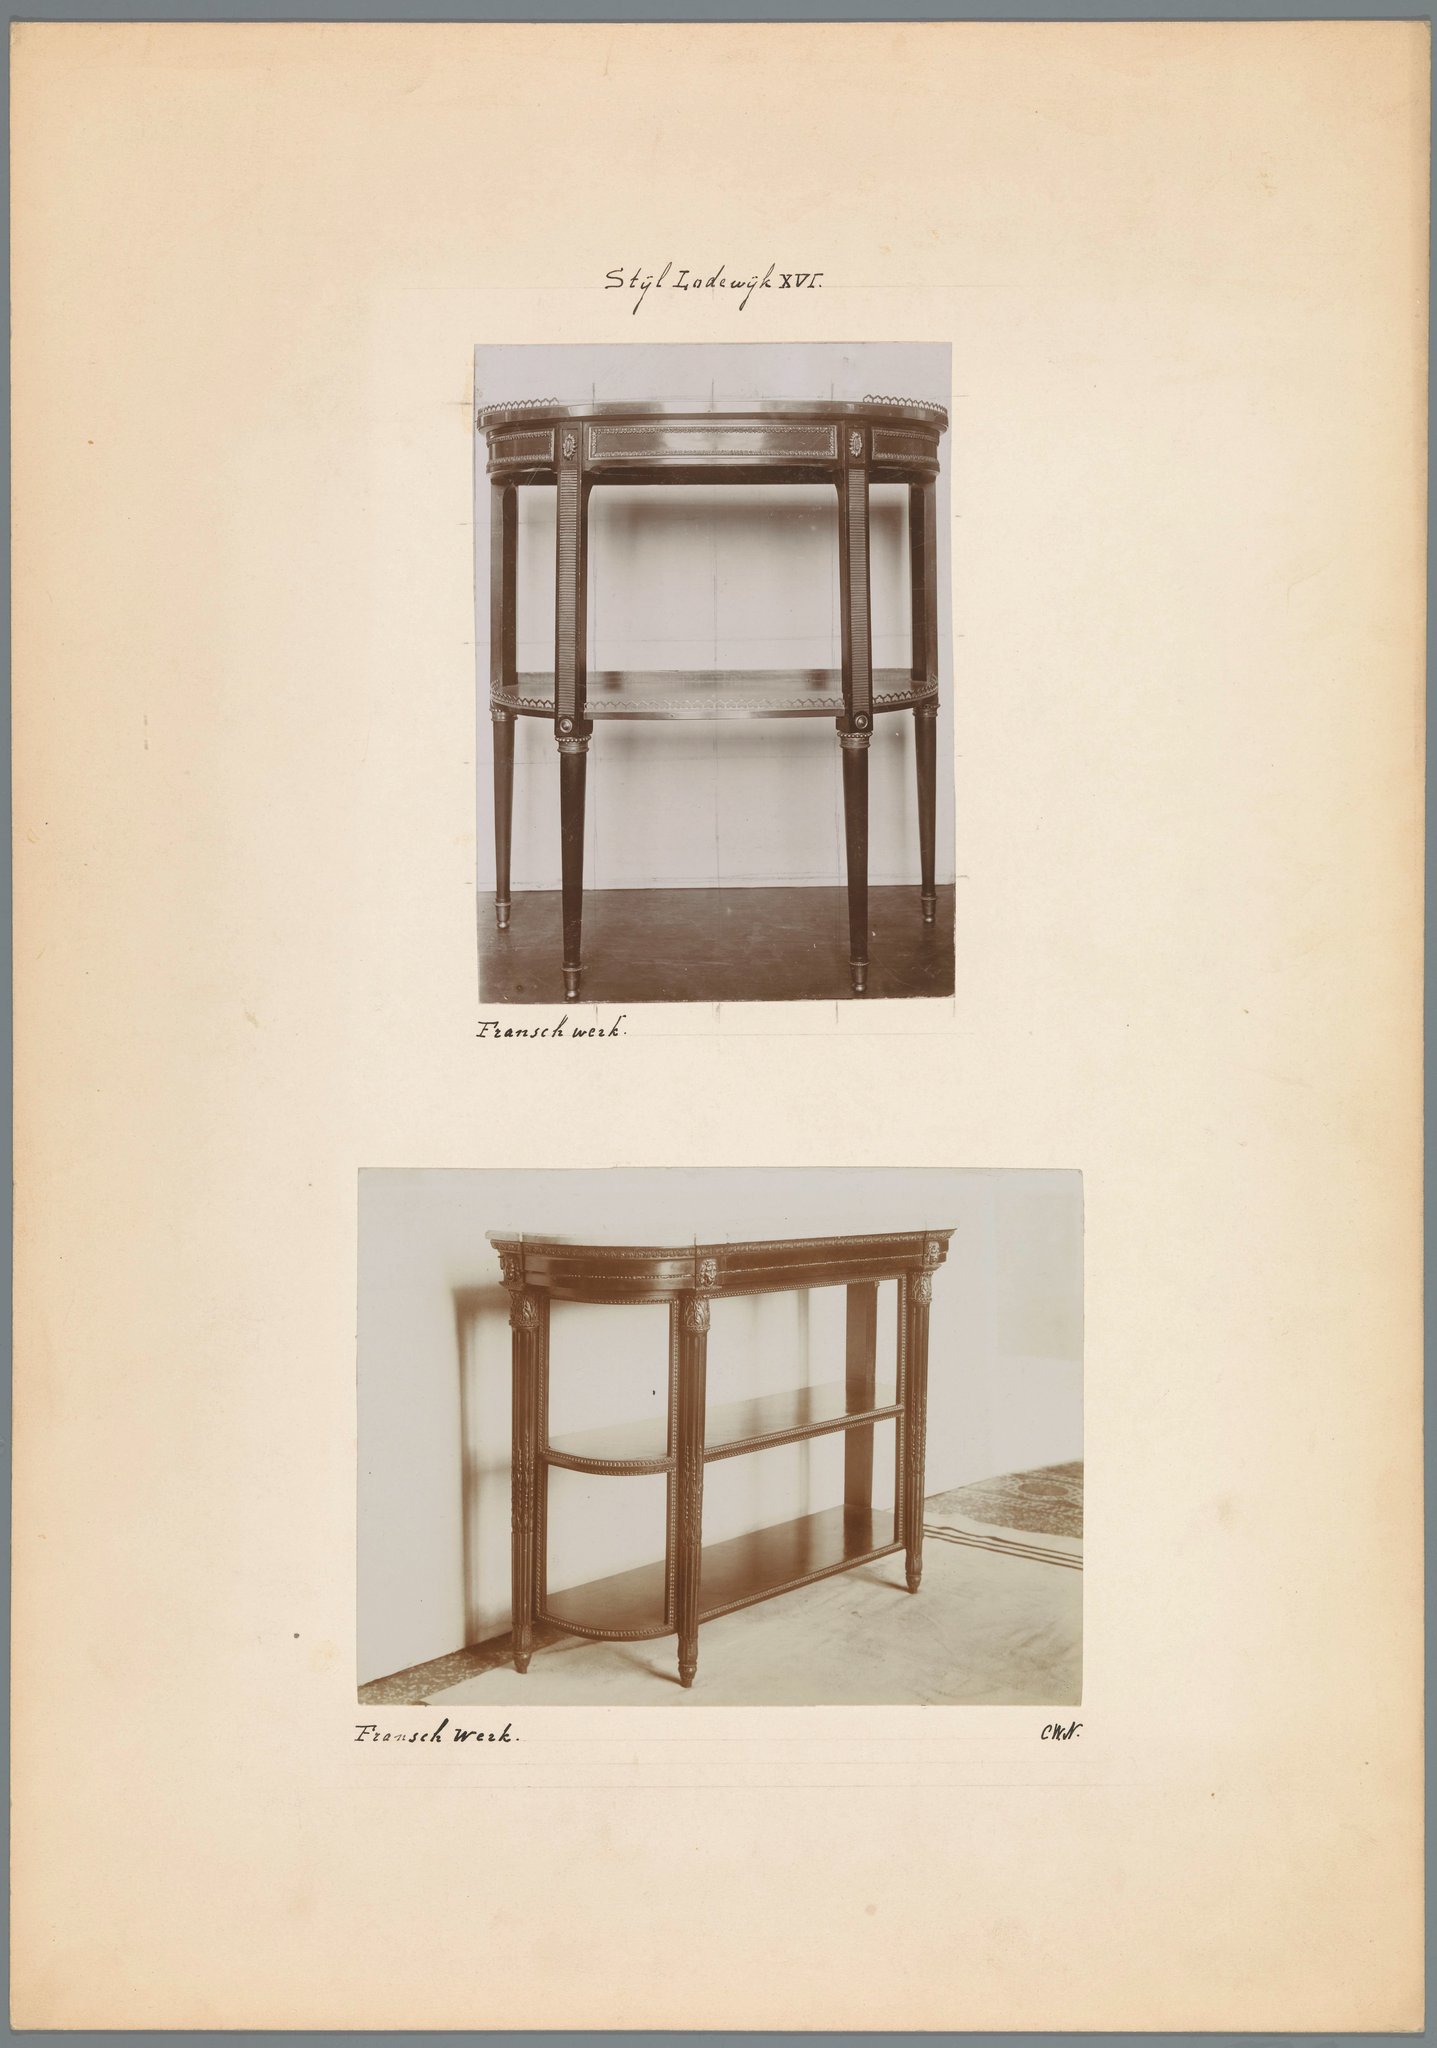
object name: photograph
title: Twee penanttafels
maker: Anonymous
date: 1875-1900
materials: cardboard, photographic support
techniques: collodion silver print, gelatin silver print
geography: europe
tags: lion's head ~ ornament, table, europe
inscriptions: inscription: ‘CWN.’, collector's mark: ‘INSTITUUT VOOR KUNST-NIJVERHEIDSONDERWIJS GABRIËL METSUSTRAAT No. 16 AMSTERDAM’, inscription: ‘Stijl Lodewijk XVI.’, collector's mark: ‘KUNSTNIJVERHEIDSCHOOL QUELLINUS AMSTERDAM FRANS HALSSTRAAT 14.’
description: Boven een penanttafel met twee half ovaalvormige marmeren bladen met galerij, onder een penanttafel met twee galerijen en gedecoreerd met leeuwenkoppen.